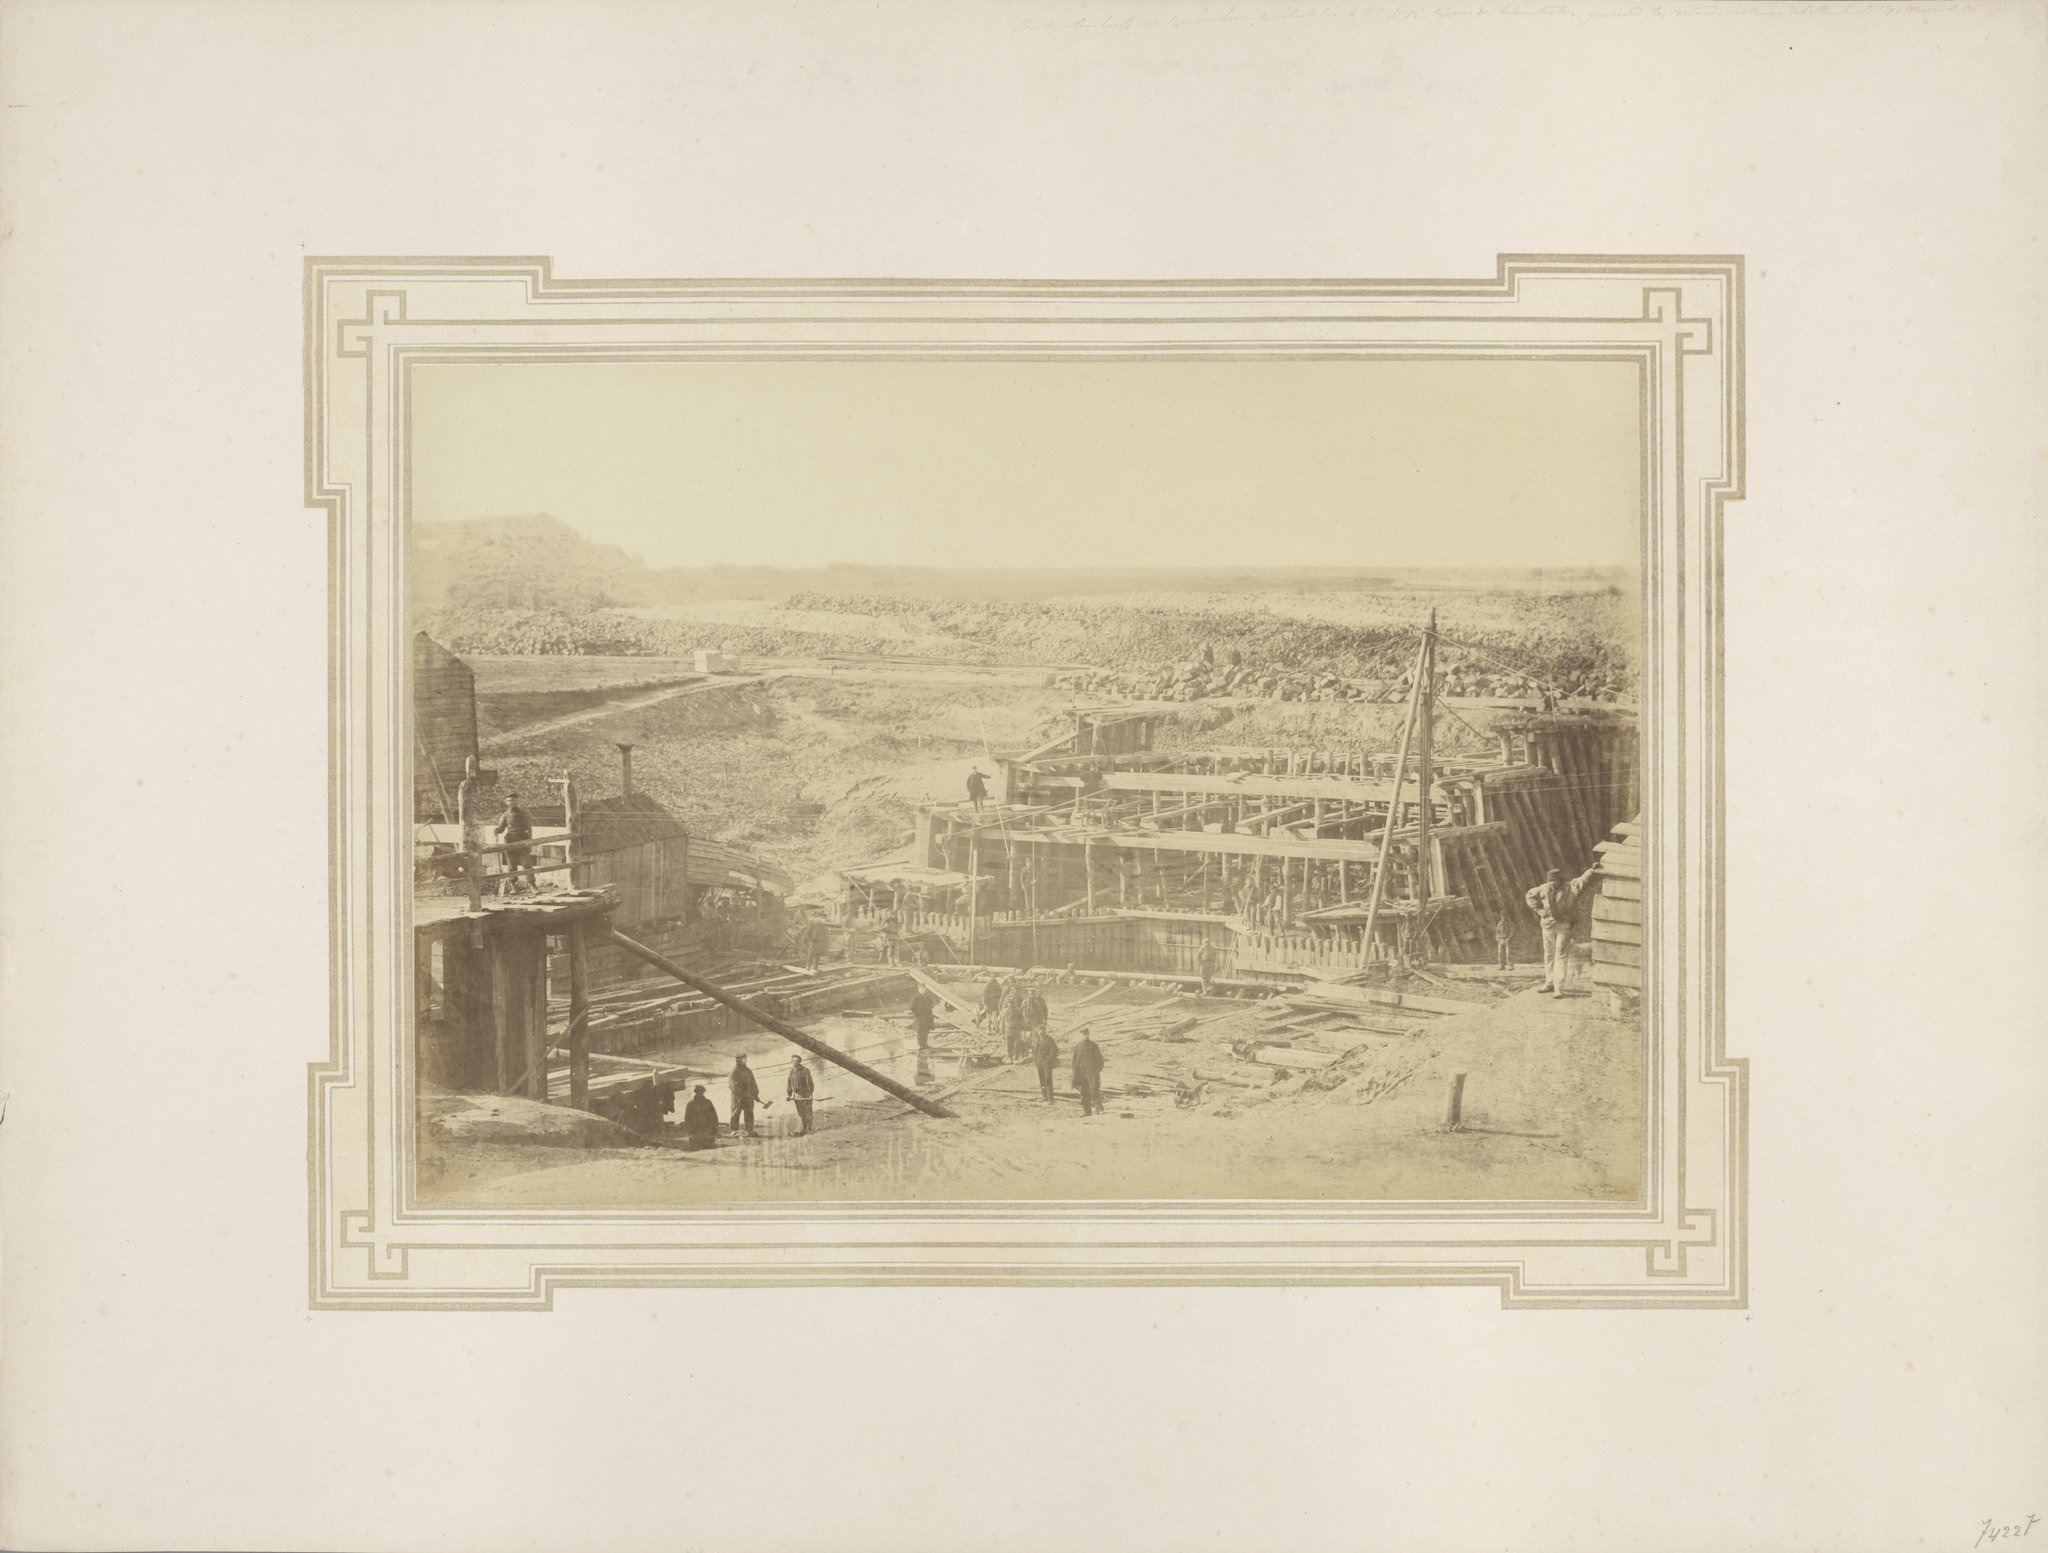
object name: photograph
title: Veertien platen betreffende de bouw van de sluis- en havenwerken te Vlissingen en het kanaal door Walcheren in juli 1869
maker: anton lauwrens preuninger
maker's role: fotograaf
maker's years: 1846-1919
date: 1807-1869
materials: cardboard, paper, photographic support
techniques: albumen print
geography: flushing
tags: sluice, weir, sea (seascape), building-site, flushing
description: Fundering van de binnenkeer- en schutsluis te Vlissingen, juli 1869. Onderdeel van een serie van veertien foto's van deze bouwprojecten in Zeeland.